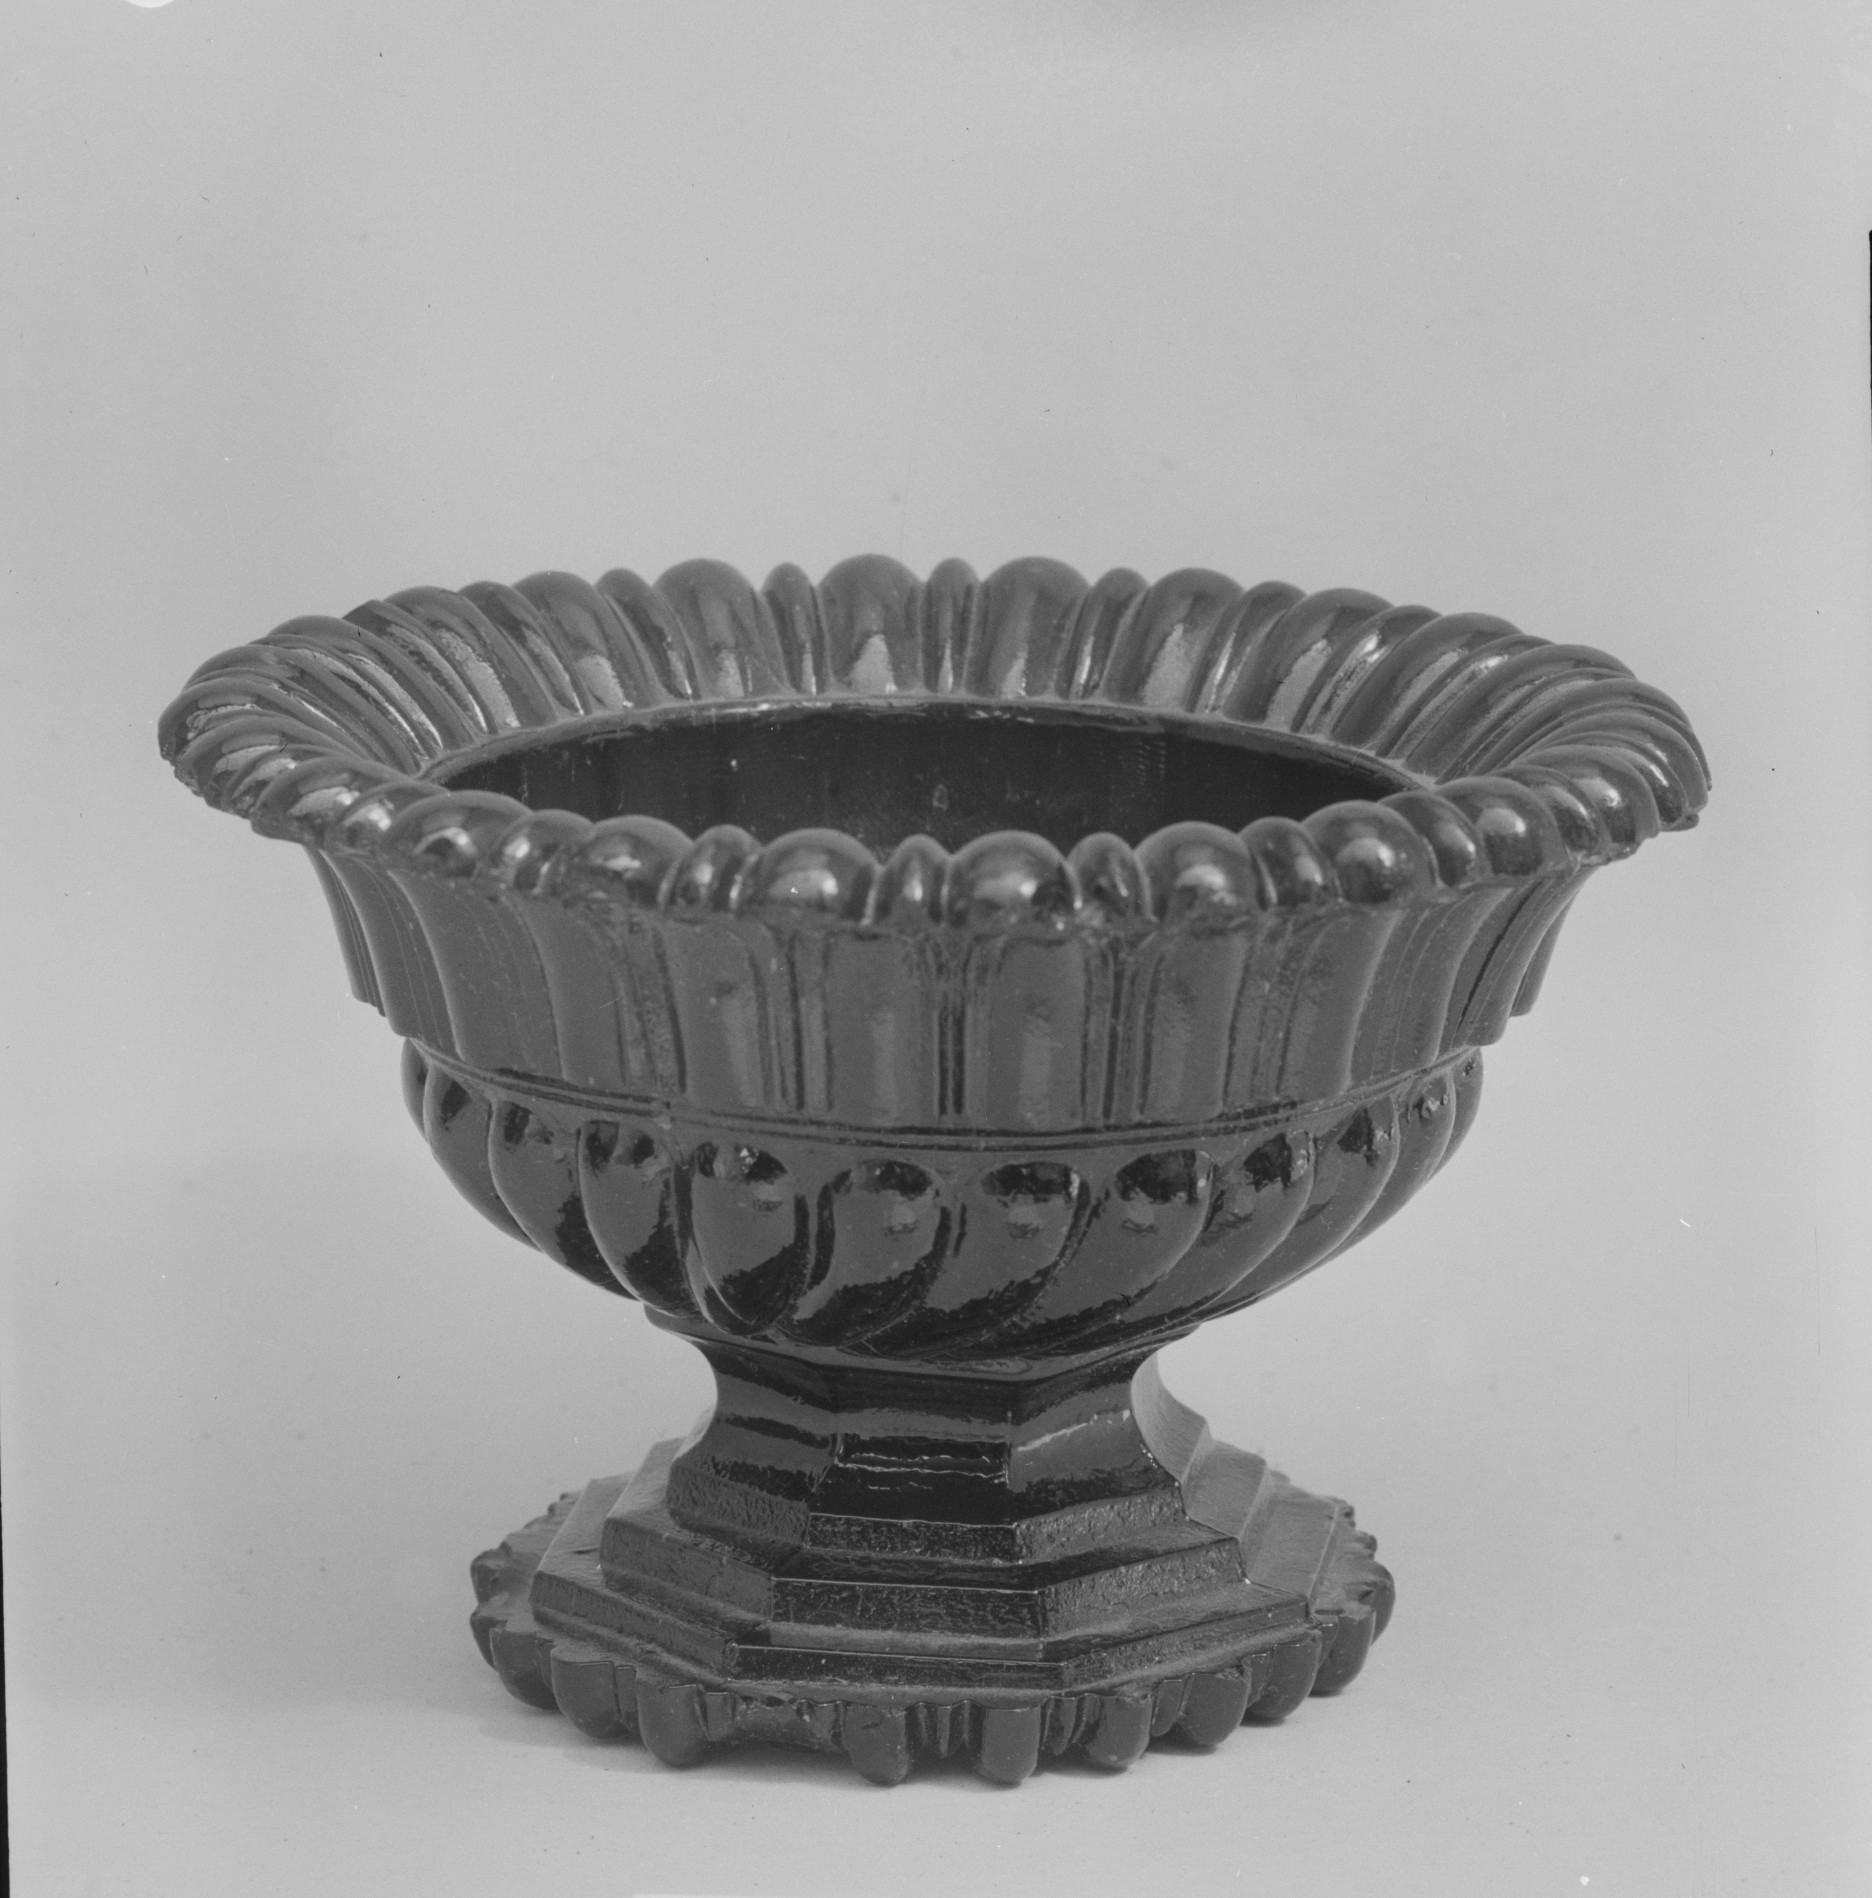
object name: bowl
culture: american or british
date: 1850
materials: glass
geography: england